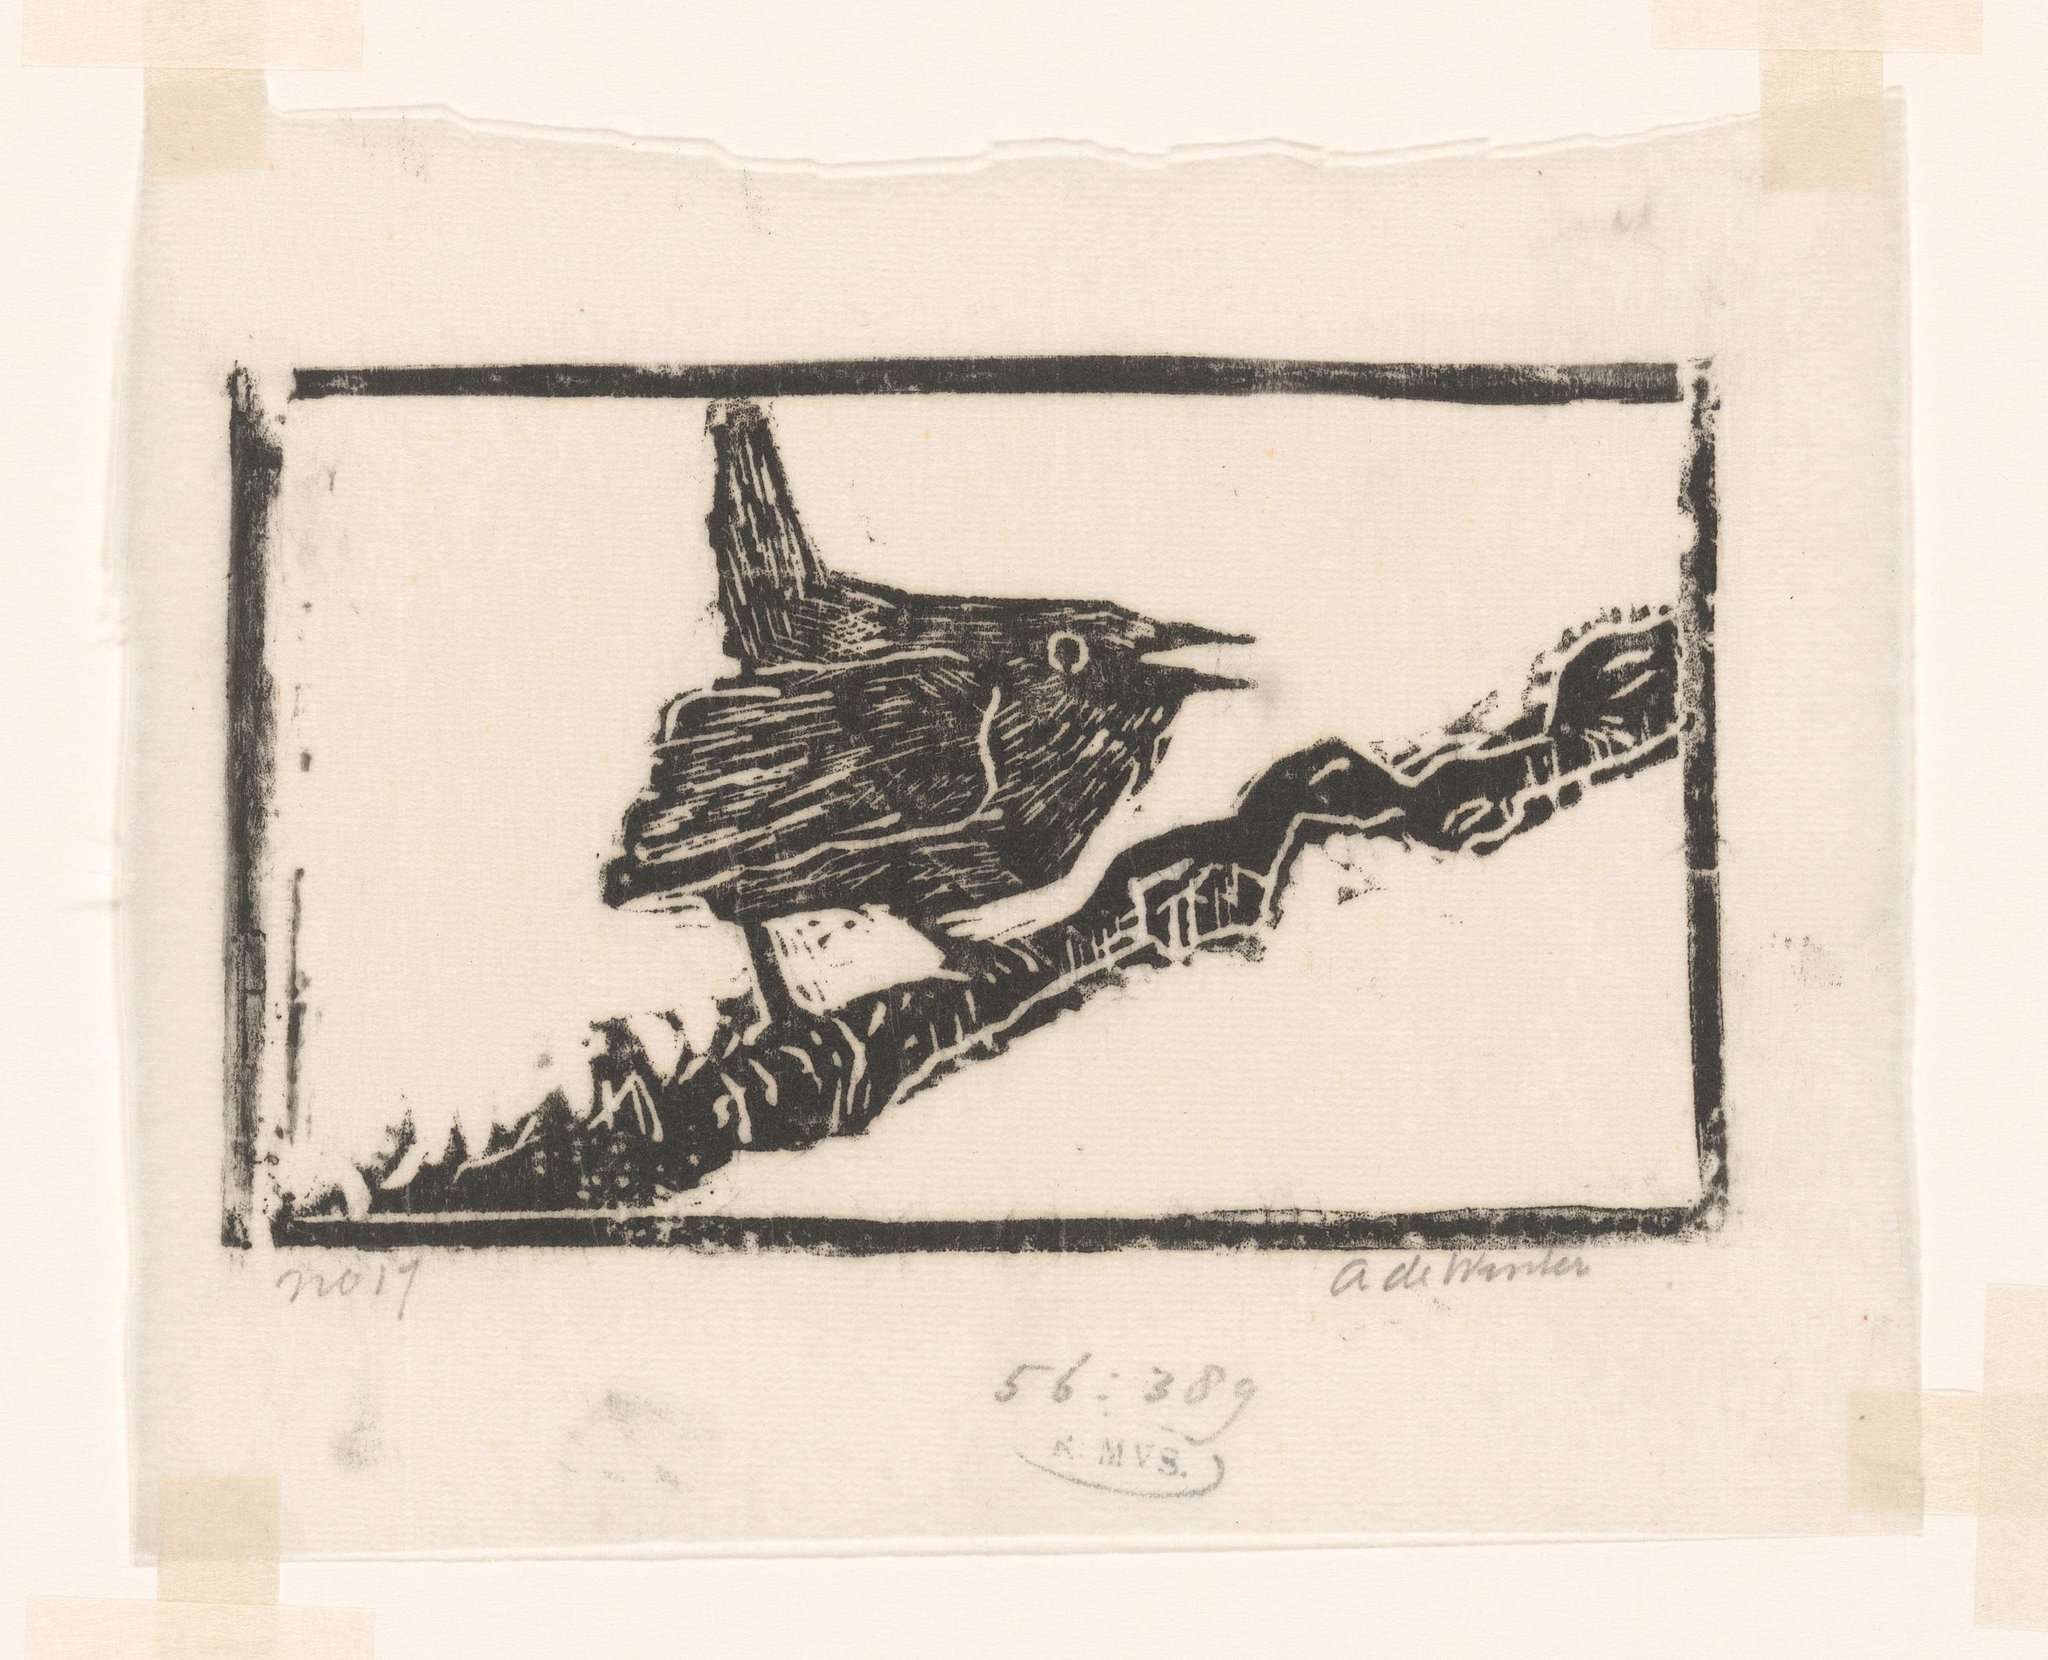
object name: print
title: Vogeltje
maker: janus de winter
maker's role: print maker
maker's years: 1882-1951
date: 1892-1951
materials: paper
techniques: linocut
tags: birds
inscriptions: inscription: ‘No 17’, collector's mark: Lugt 2228